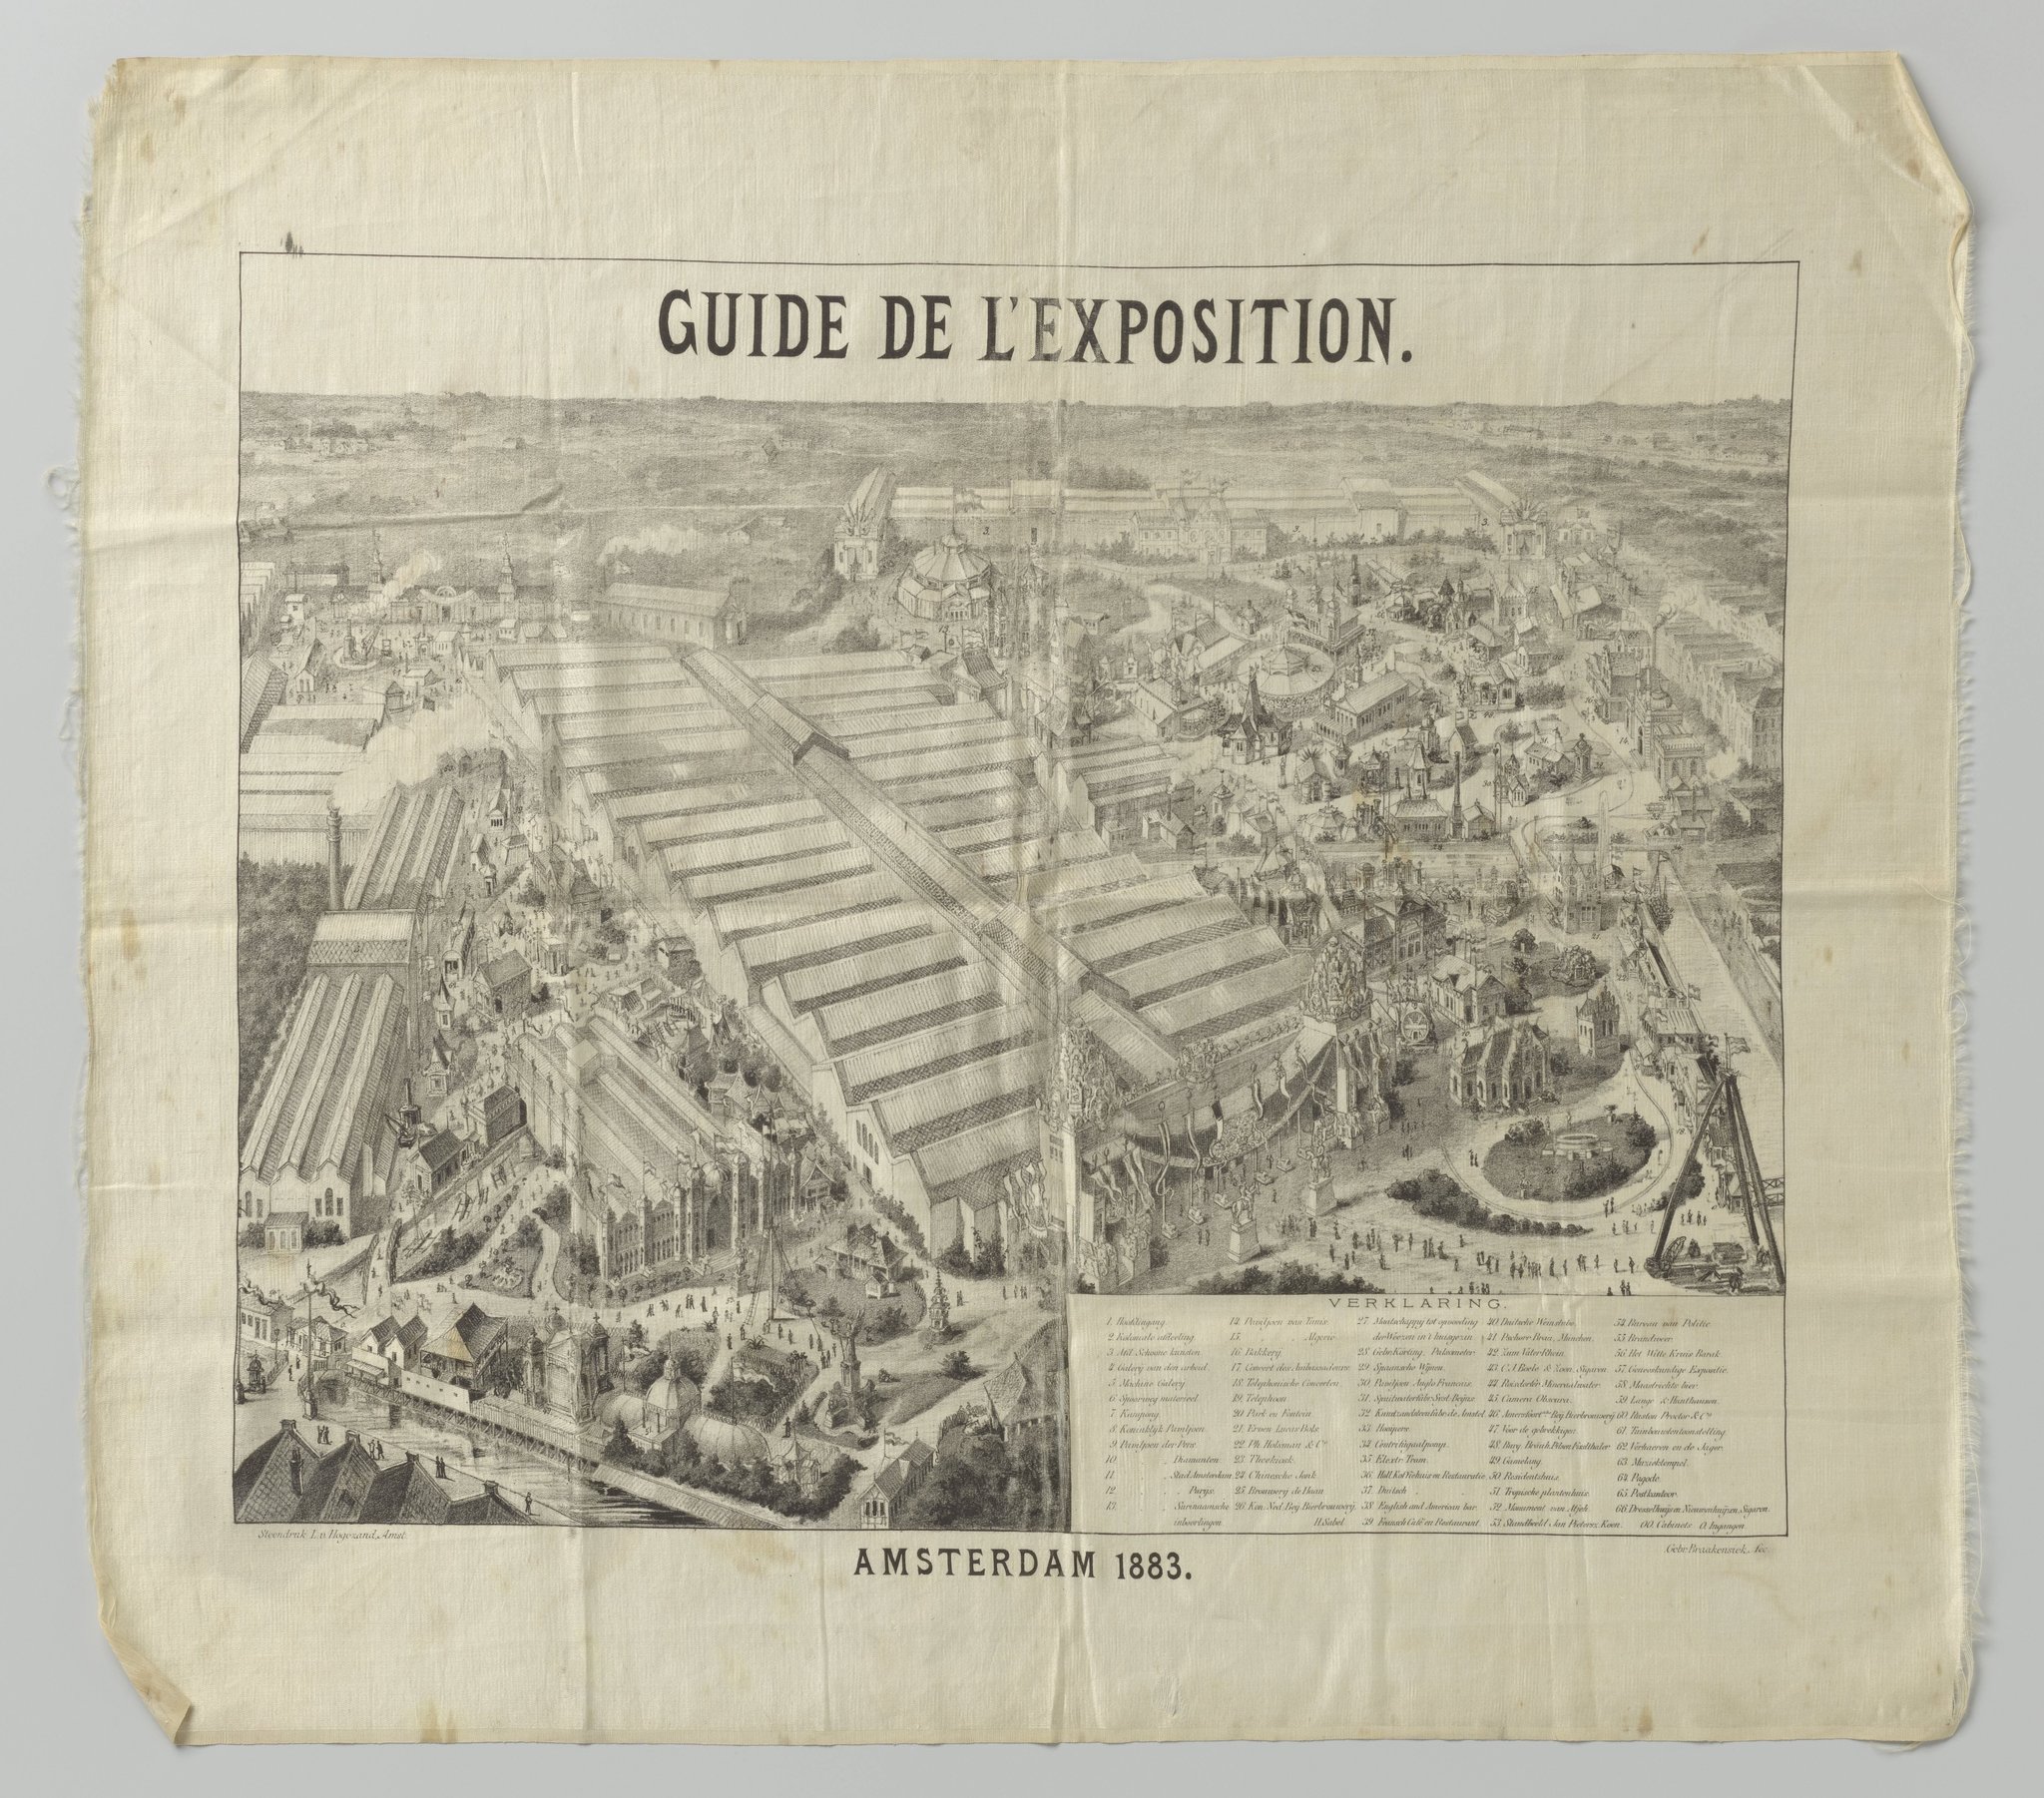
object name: cloth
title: Herinneringsdoek van de Koloniale tentoonstelling Amsterdam 1883 in litho op zijde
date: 1883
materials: silk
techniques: lithograph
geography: netherlands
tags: amsterdam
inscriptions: date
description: Herinneringsdoek van de Koloniale tentoonstelling Amsterdam, 1883, in litho op zijde.